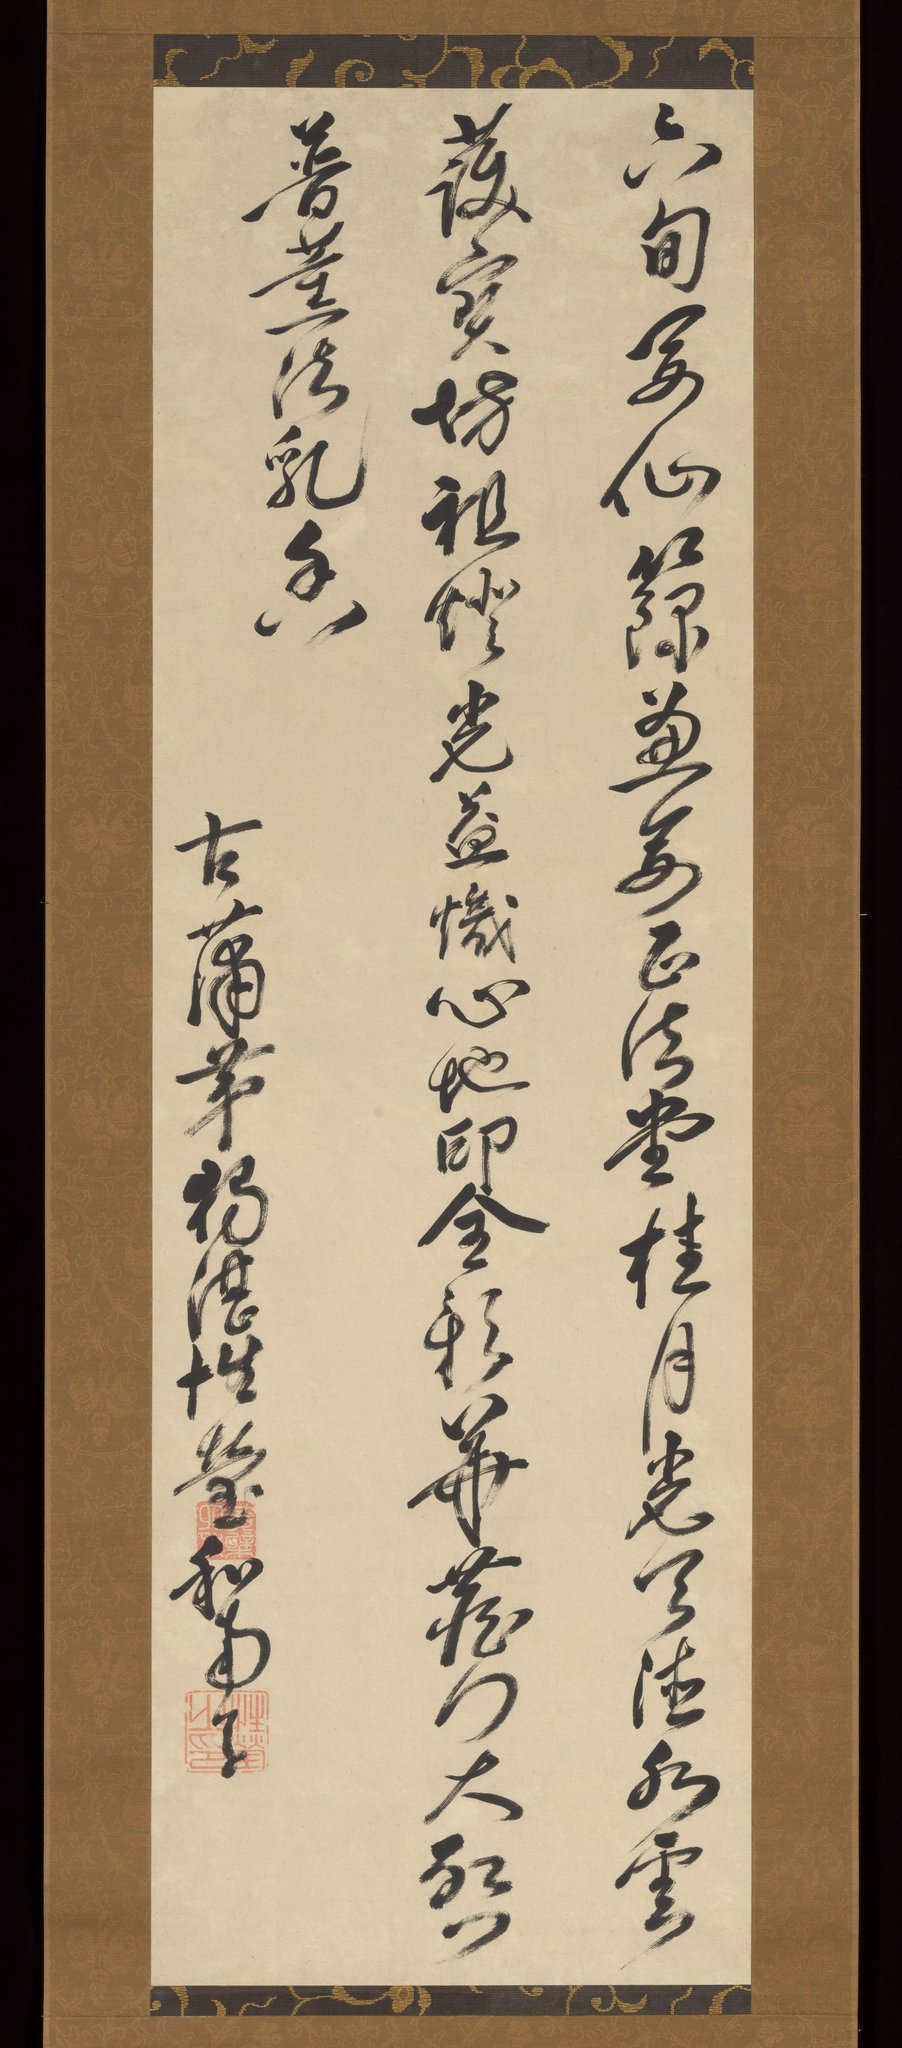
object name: hanging scroll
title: Chinese Poem to Celebrate a Senior Monk’s Sixtieth Birthday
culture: japanese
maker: duzhan xingying (japanese: dokutan shōkei)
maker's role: artist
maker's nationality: chinese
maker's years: 1628-1706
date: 1667-1733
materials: ink, paper